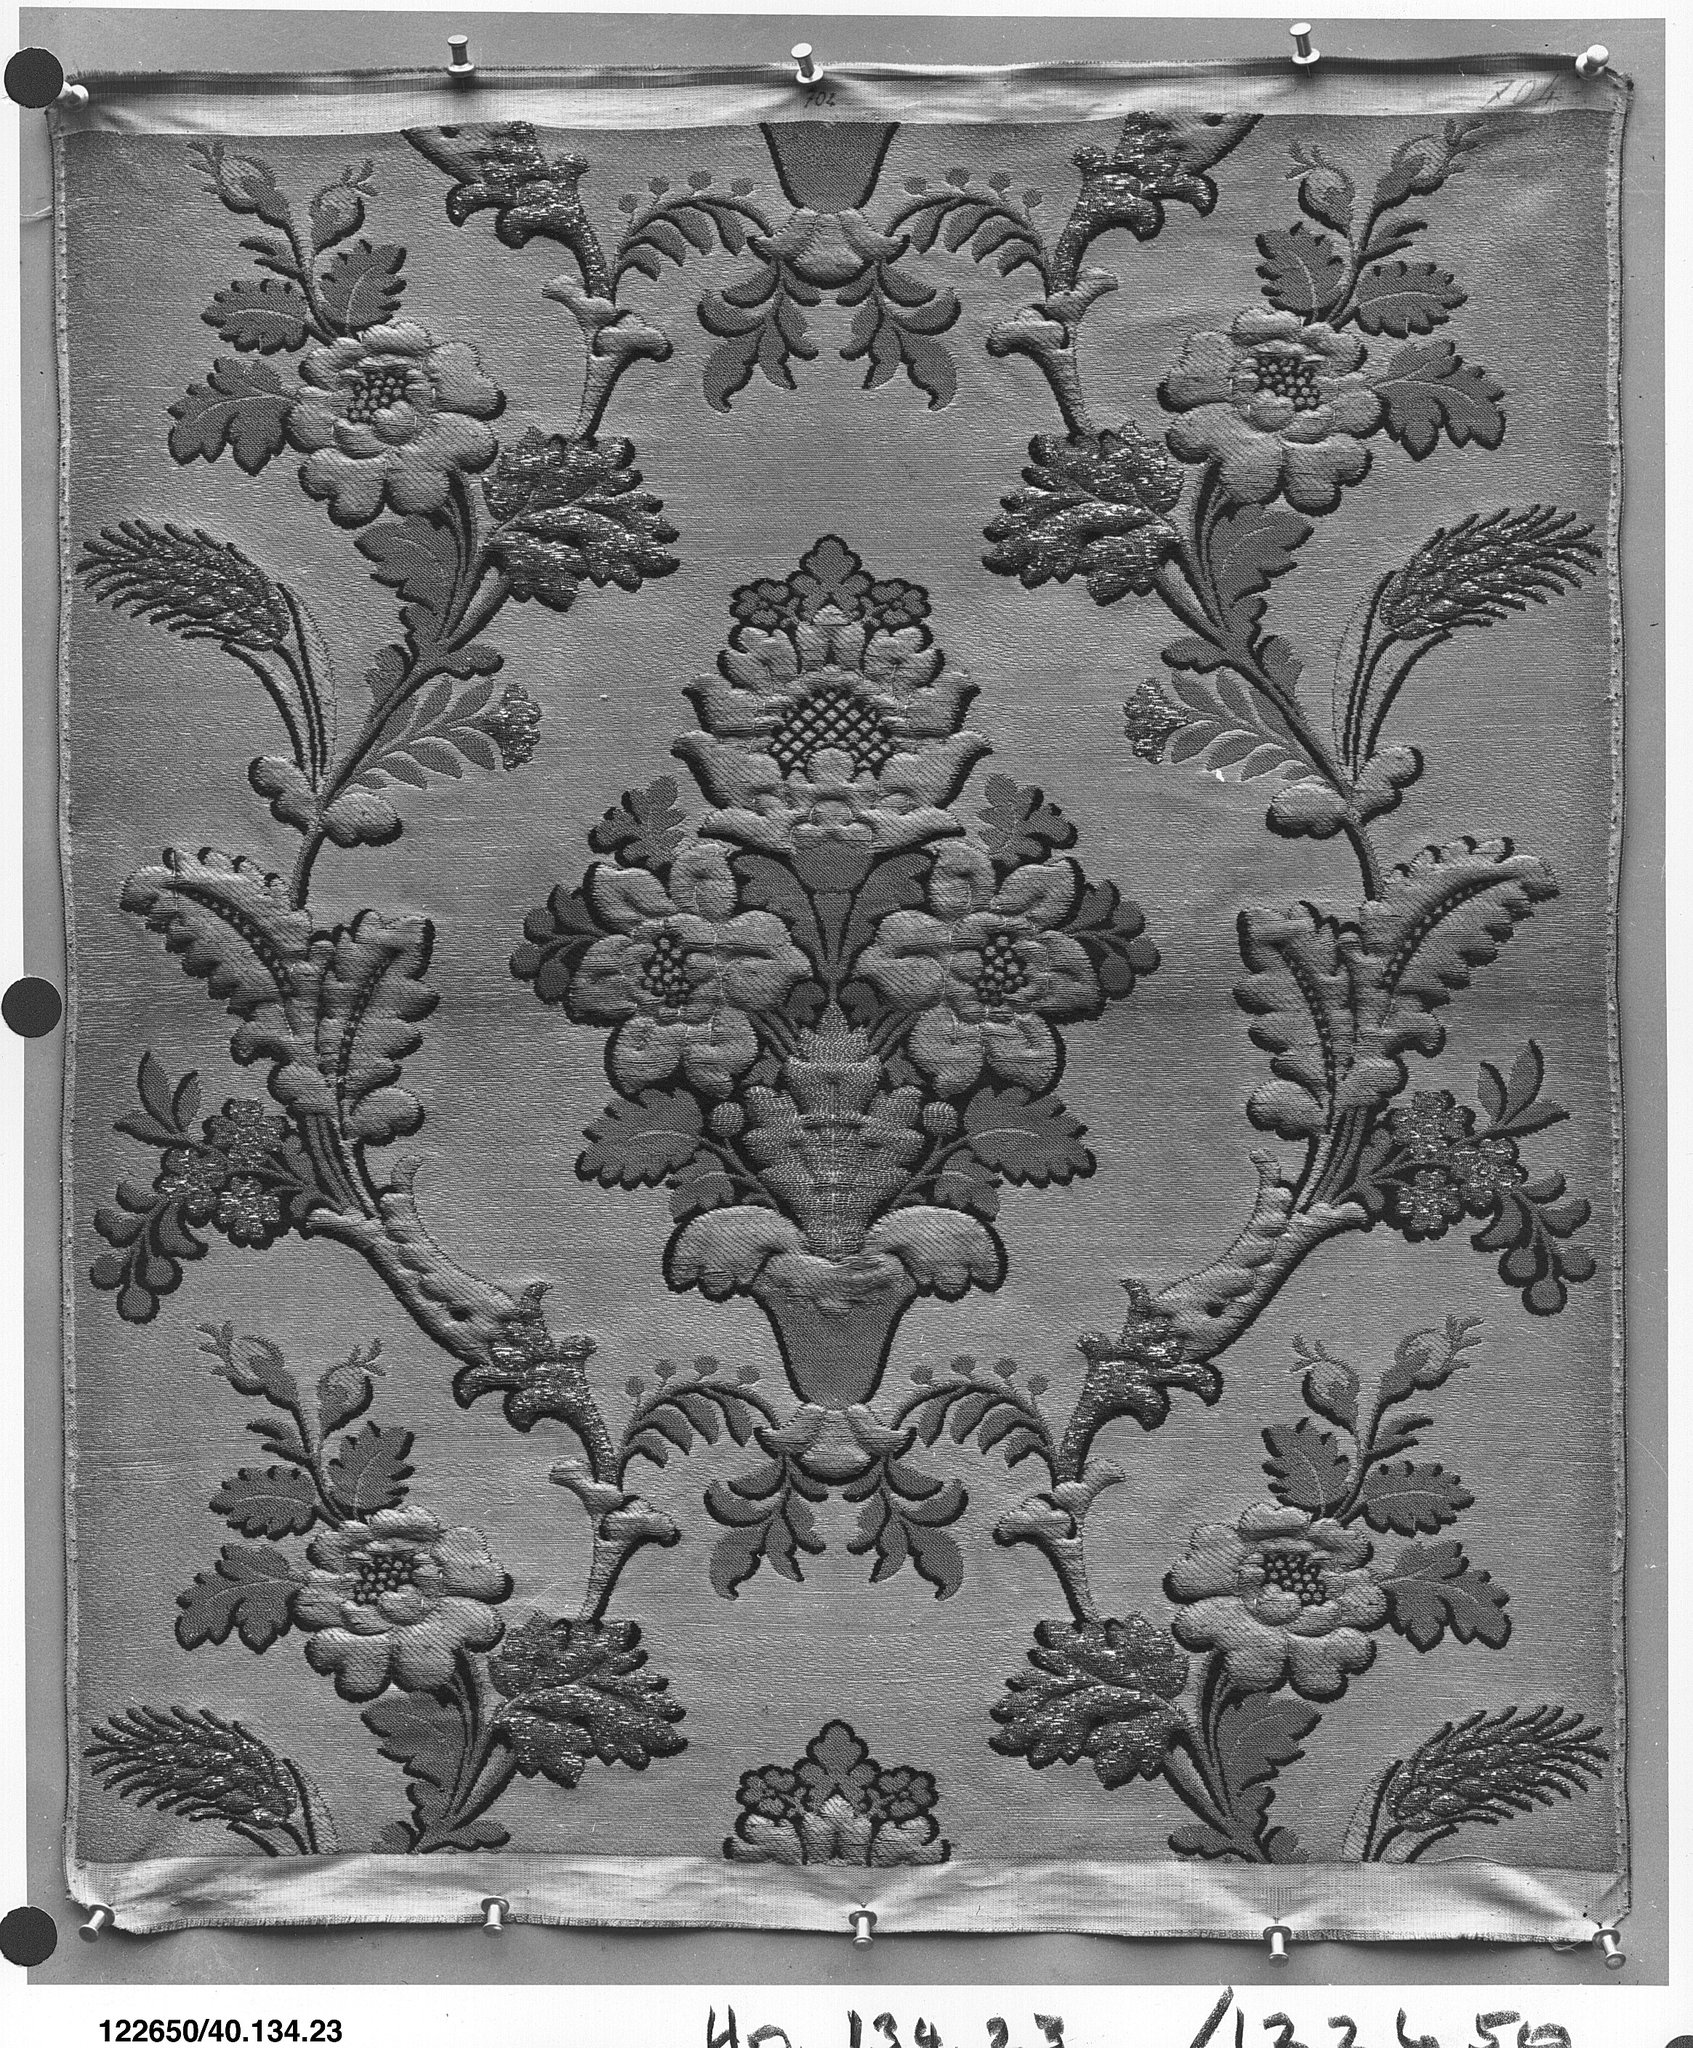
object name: piece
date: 1701-1900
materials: metal thread, silk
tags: flowers,leaves